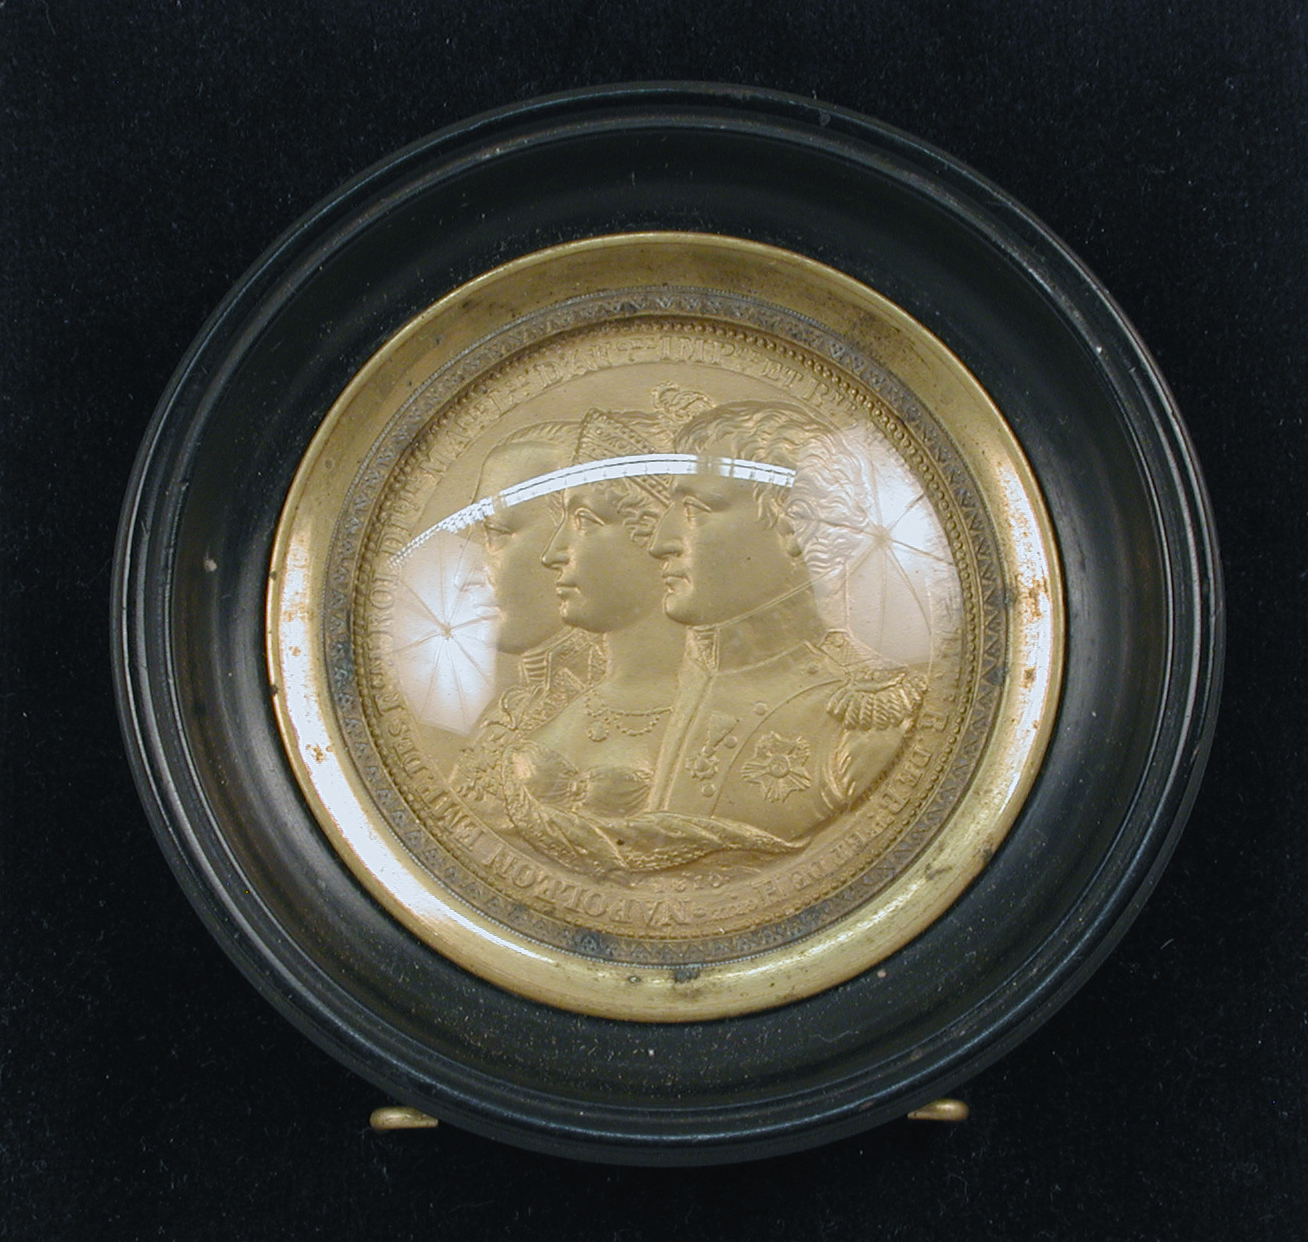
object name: medallion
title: Napoleon (1769–1821), Marie Louise (1791–1847) and François II (1768–1835)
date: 1810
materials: brass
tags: men,profiles,women